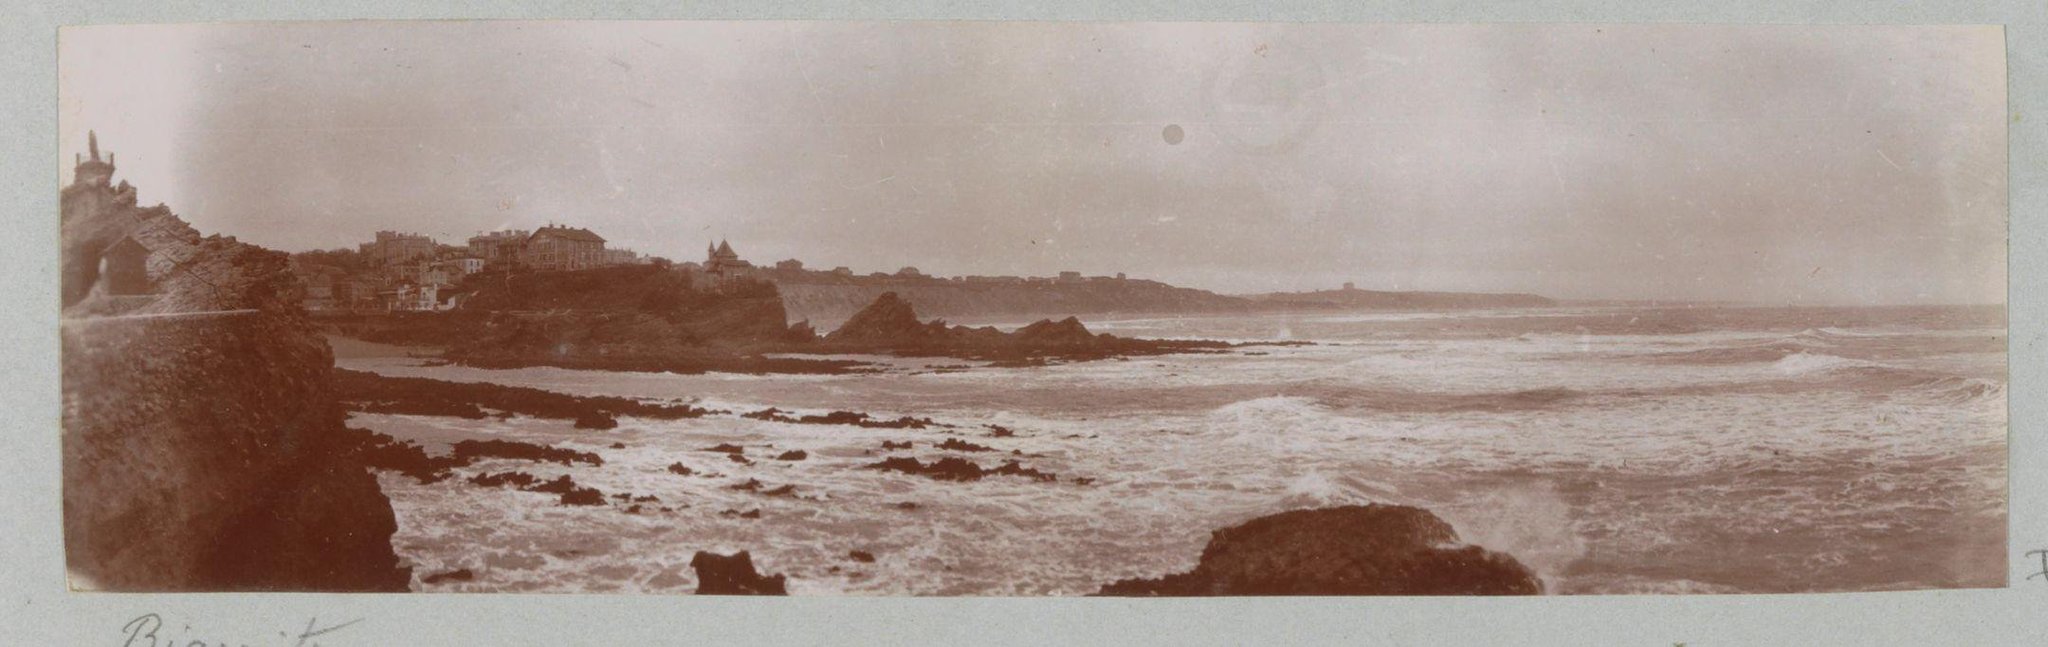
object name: panoramic photograph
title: Gezicht op Biarritz met zee, rotsen en branding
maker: delizy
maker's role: manufacturer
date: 1904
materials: paper, photographic support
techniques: gelatin silver print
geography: biarritz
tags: surf, breakers, beach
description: Onderdeel van Fotoalbum van een Franse amateurfotograaf met opnames van uitstapjes in Frankrijk, Spanje, België, Luxemburg en Nederland, de eerste automobielen en autoraces.